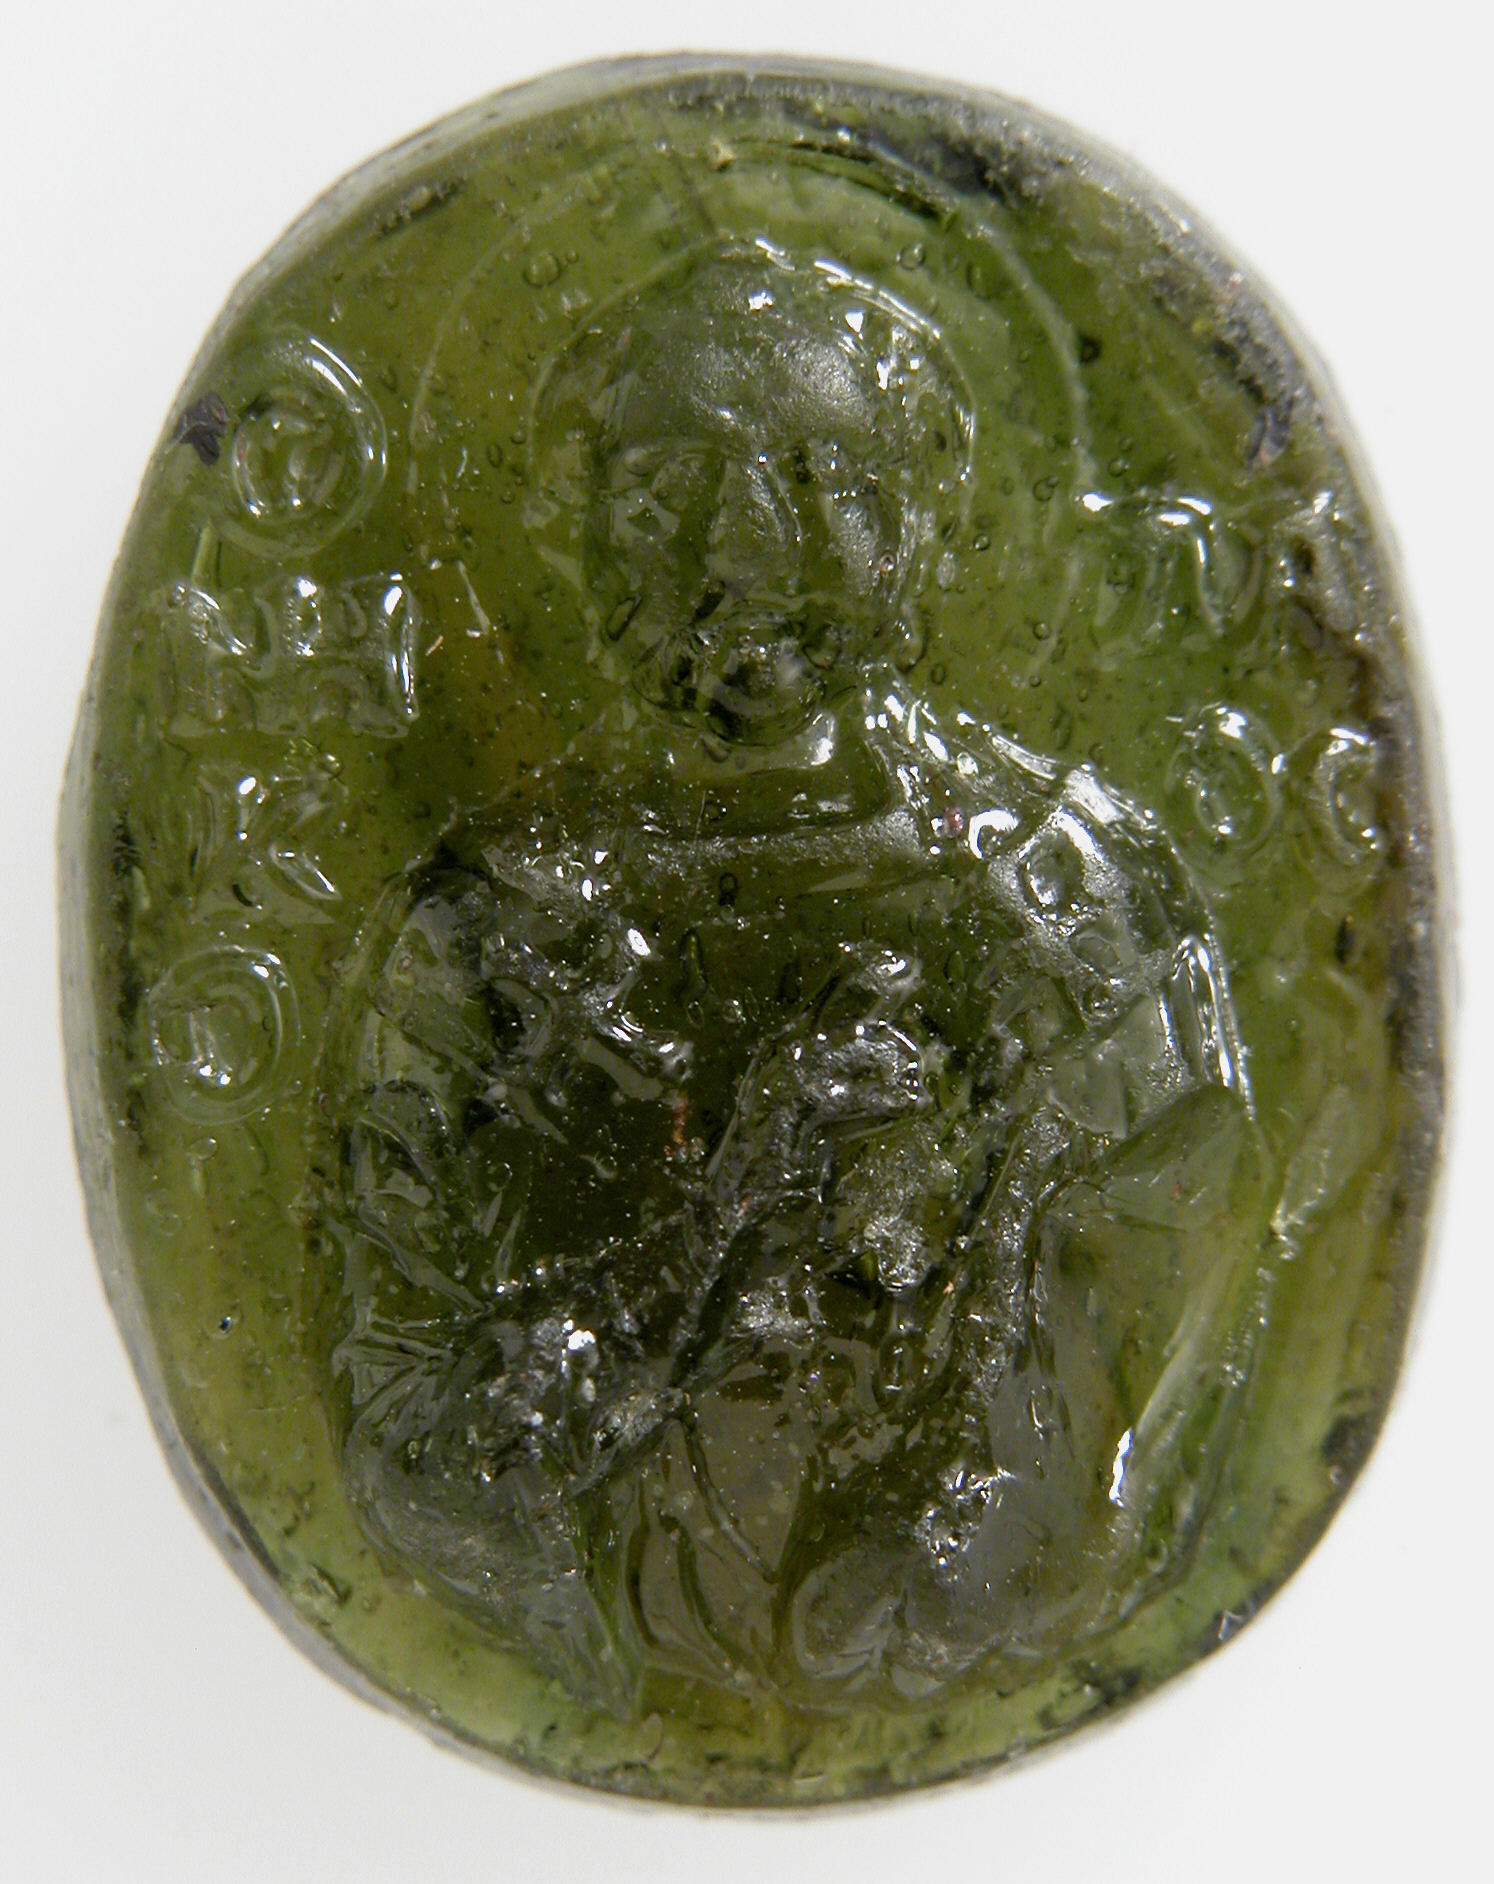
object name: cameo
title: Cameo with Saint Nicholas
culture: byzantine or italian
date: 1101-1300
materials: glass, paste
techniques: molding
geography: venice ?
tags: cameos